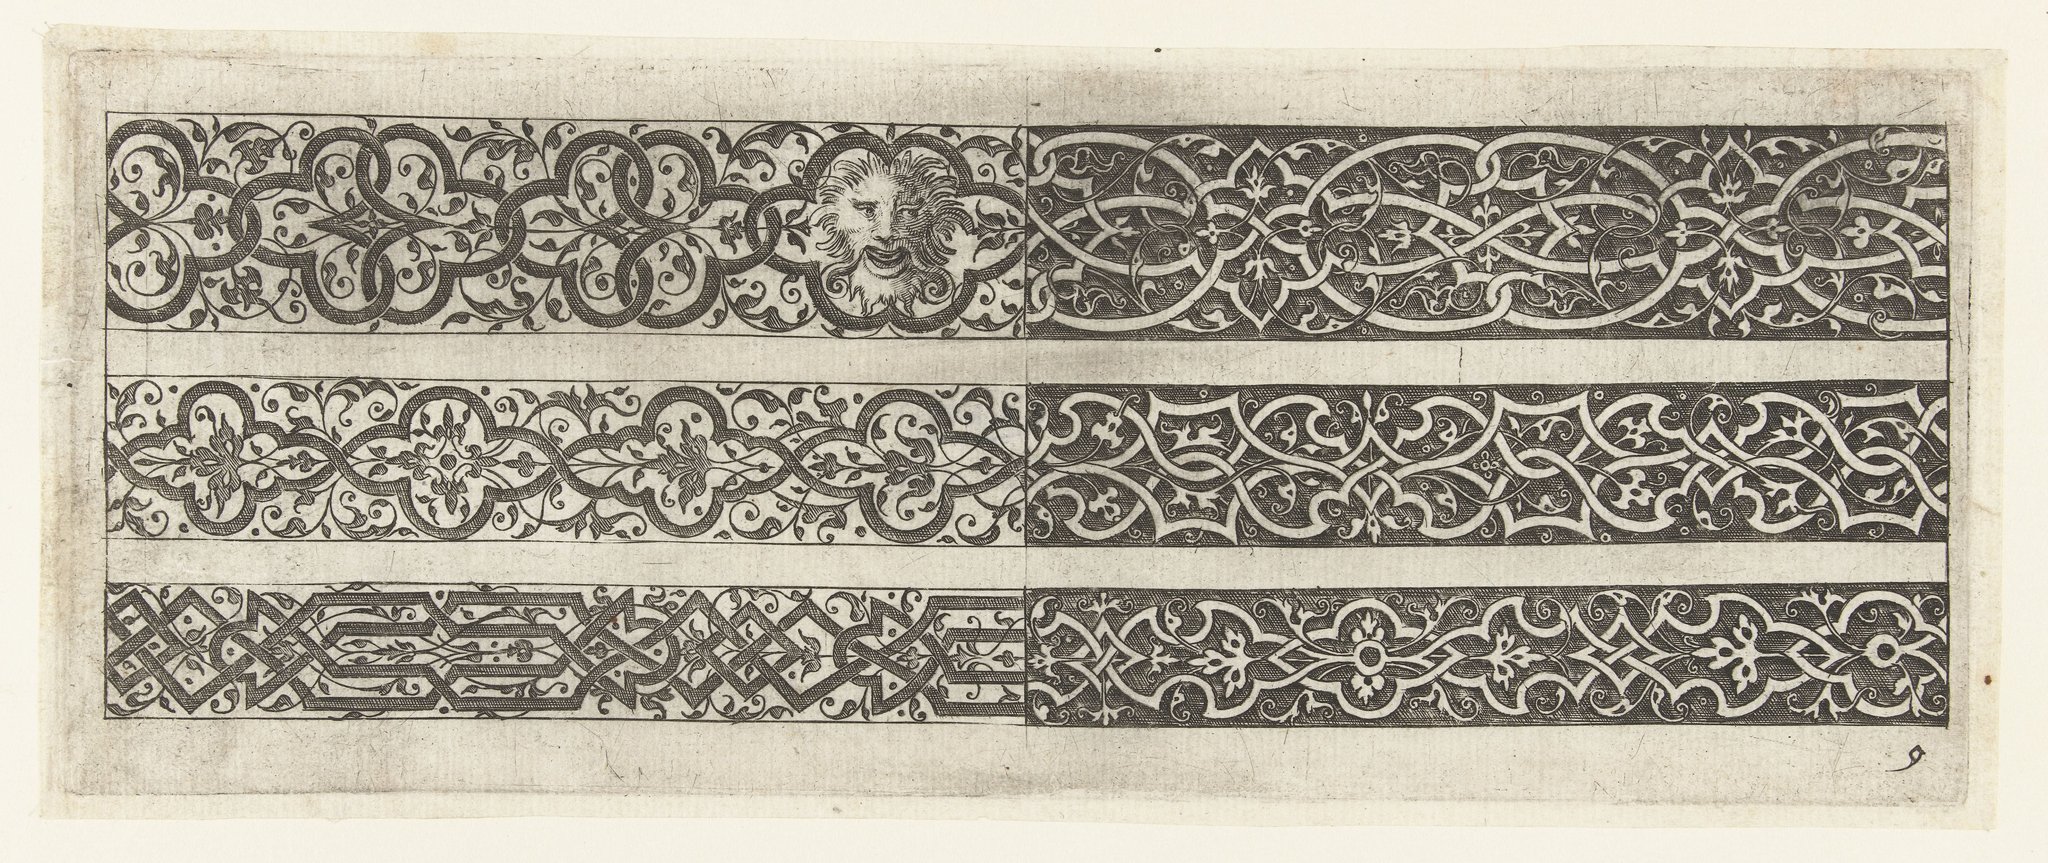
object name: ornament print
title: Drie friezen boven elkaar, in het bovenste fries bevindt zich een mascaron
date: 1550-1580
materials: paper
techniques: engraving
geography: netherlands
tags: mask, mascaron ~ ornament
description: Drie friezen boven elkaar, waarvan de linker helft bestaat uit zwarte moresken op een witte achtergrond en de rechter helft uit witte moresken op een donker fond. In het bovenste fries bevindt zich een mascaron. Blad 9 van 15 bladen afkomstig uit een serie van 23 friezen met titelblad.